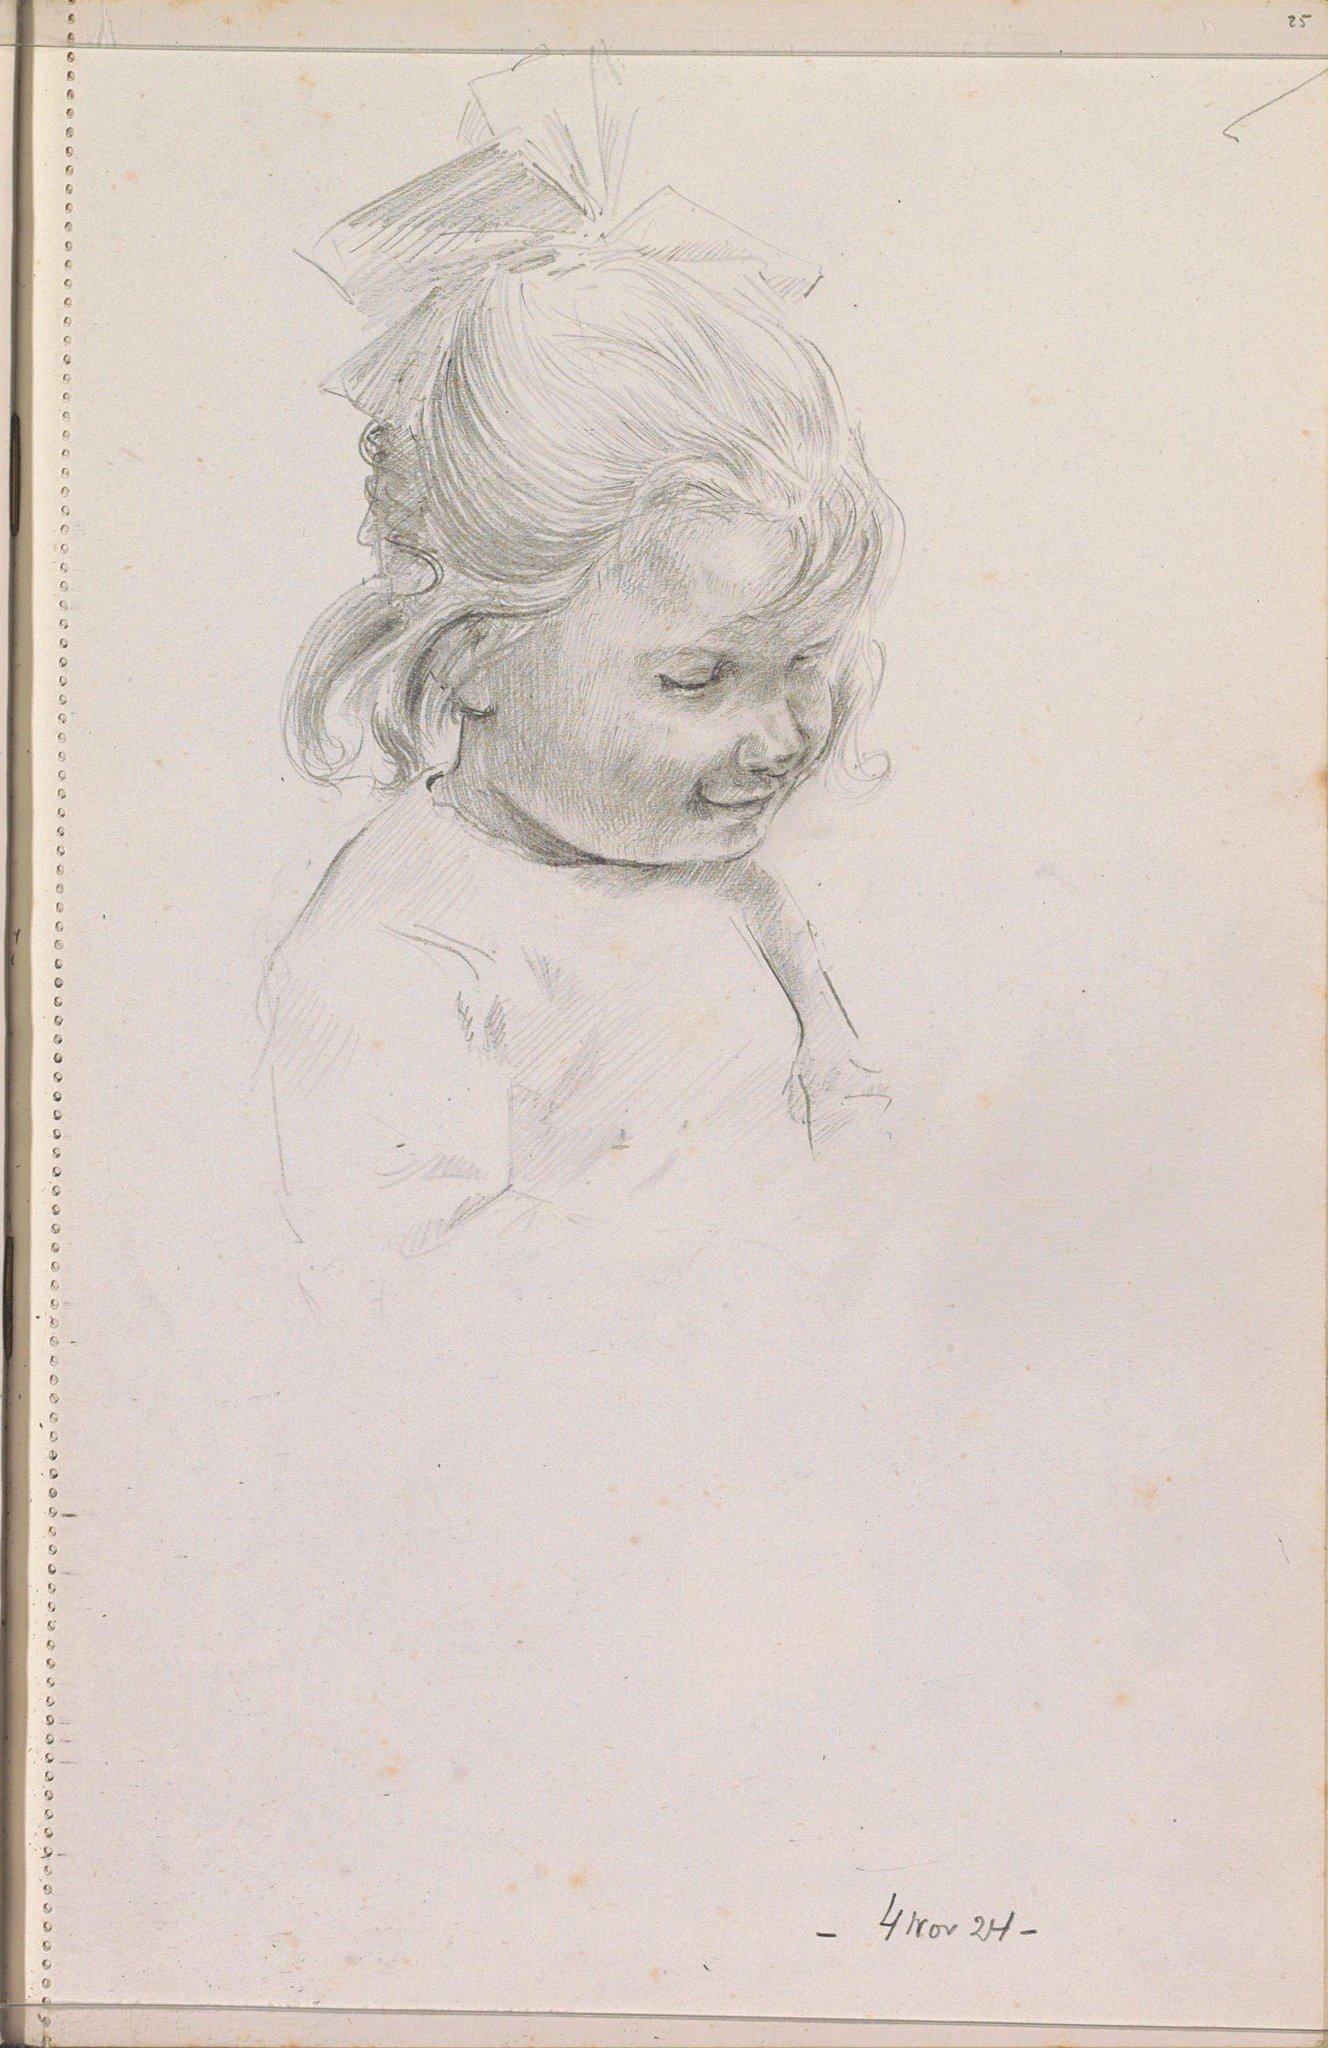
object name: sketchbook leaf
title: Portret van een meisje met een strik in het haar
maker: otto verhagen (i)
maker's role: draughtsman, print maker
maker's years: 1885-1951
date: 1911-1924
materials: paper, pencil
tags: smiling, girl (child between toddler and youth)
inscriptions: date: ‘- 4 nov 24 -’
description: Pagina 25 uit een schetsboek met 34 bladen.